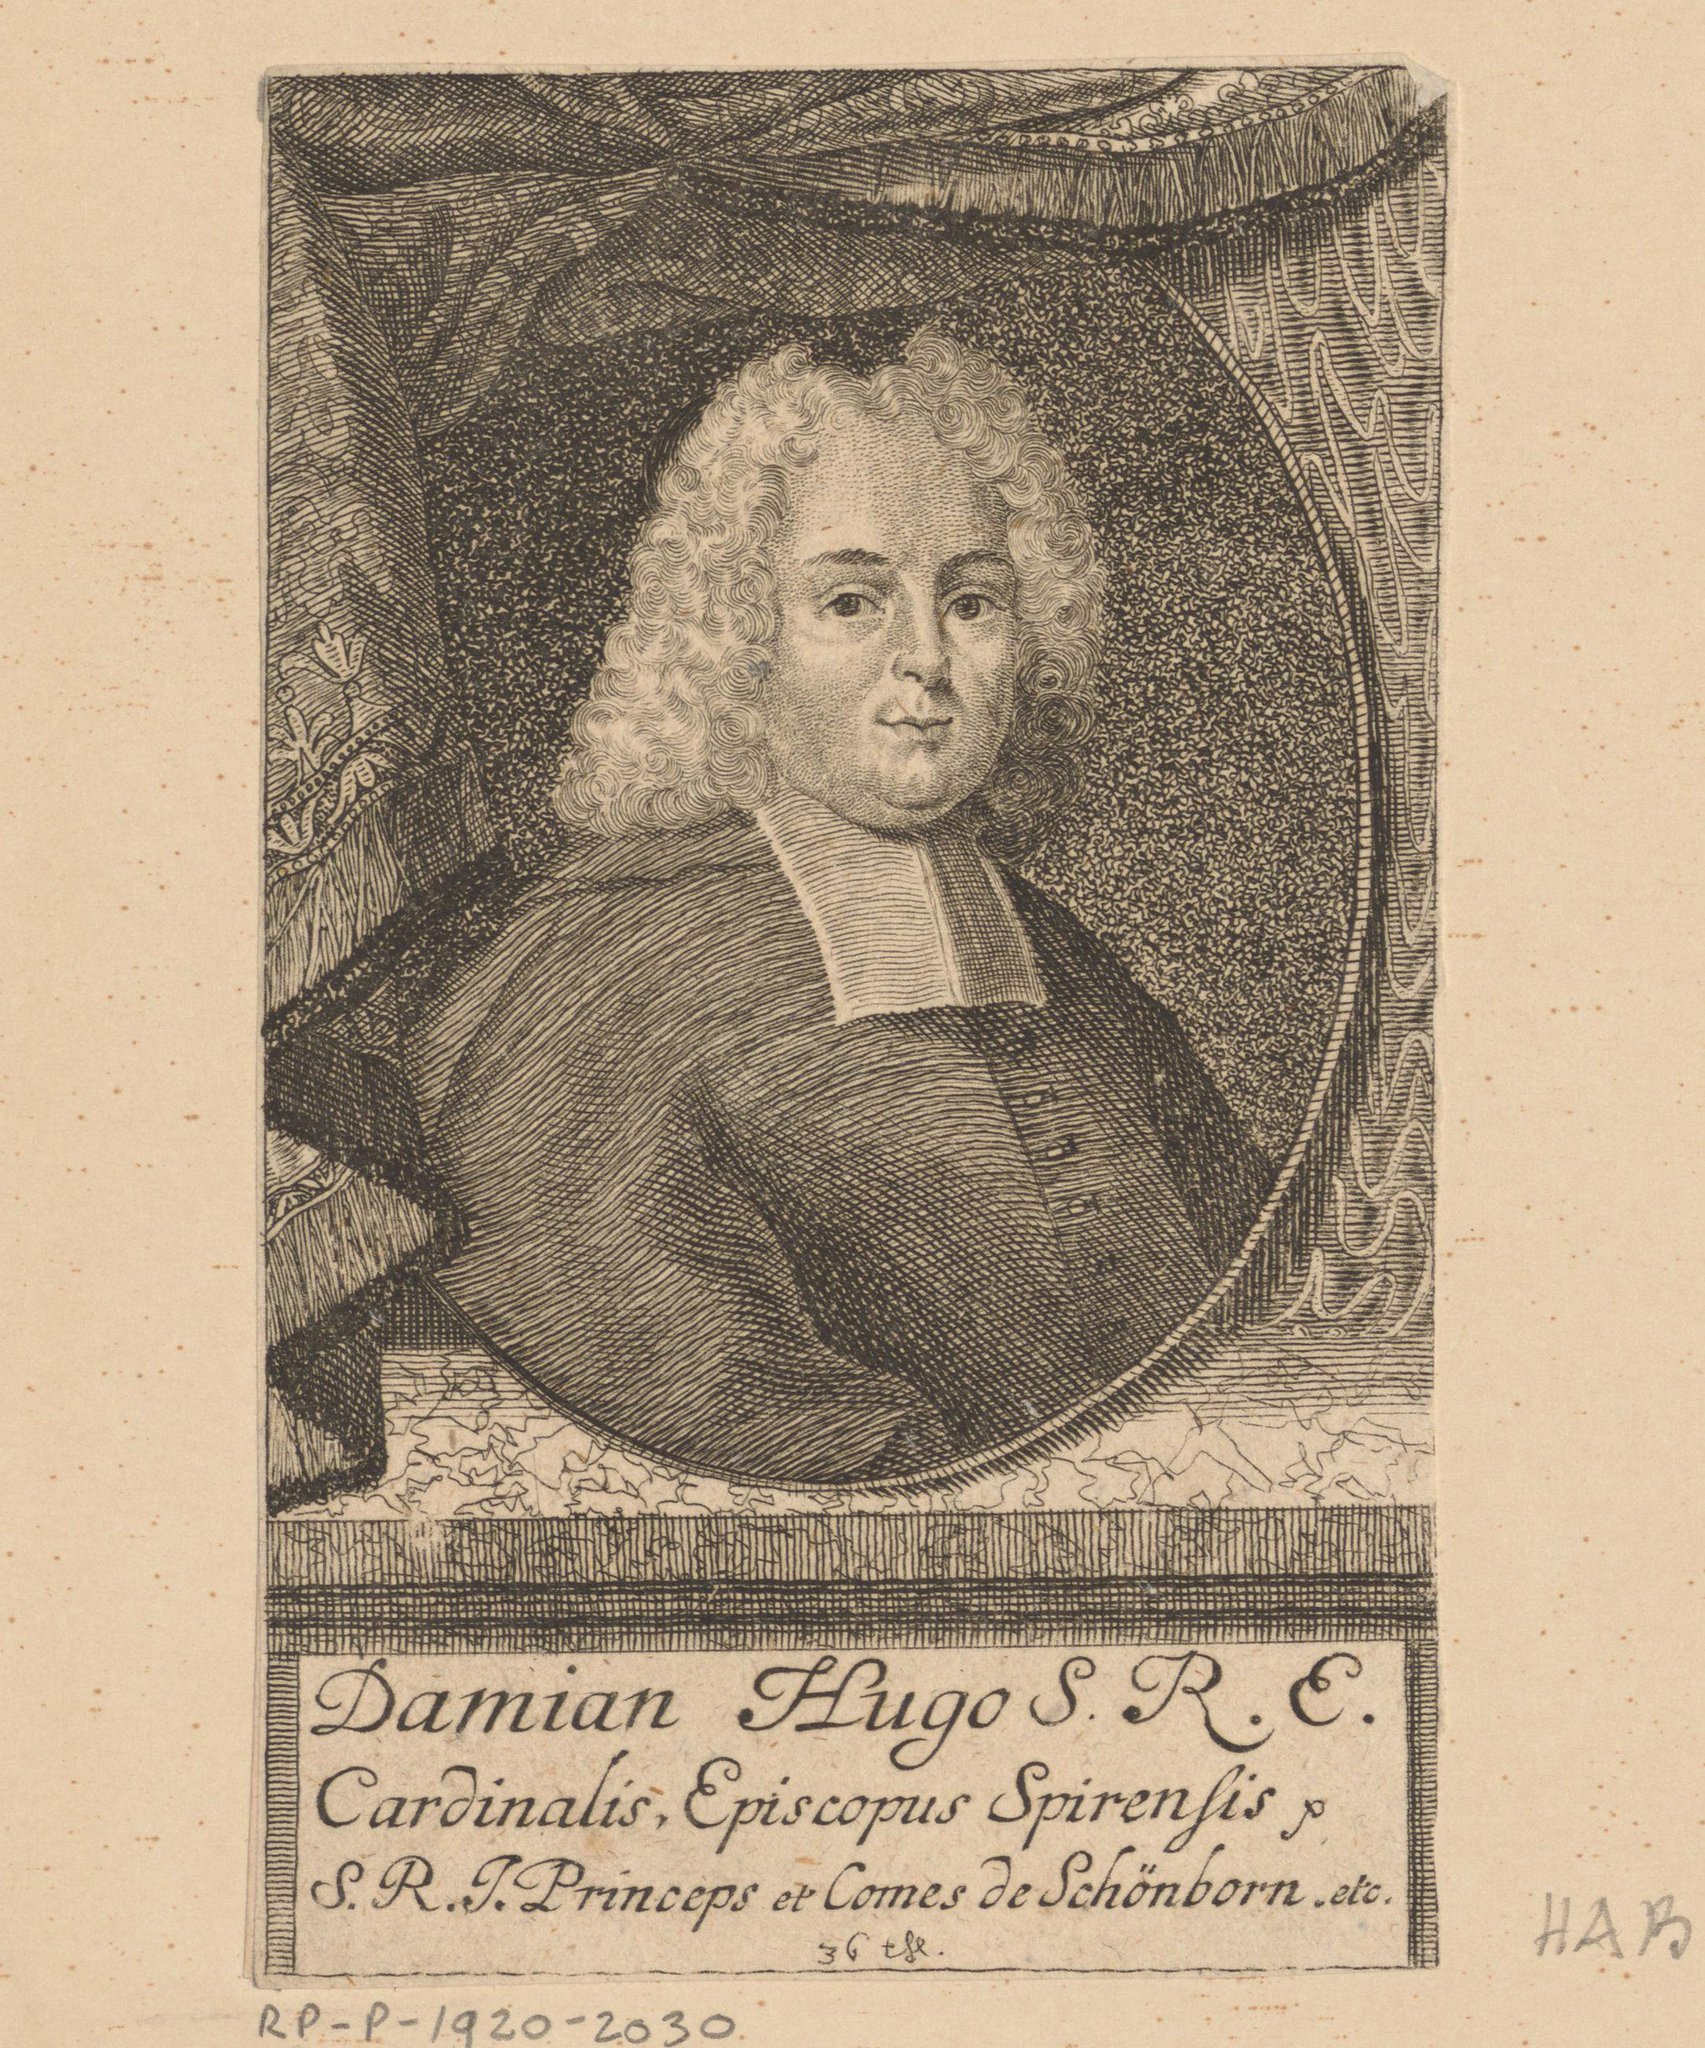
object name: print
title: Portret van Damian Hugo Philipp, graaf van Schönborn en Reichelsberg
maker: Anonymous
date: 1721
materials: paper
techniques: engraving, etching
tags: archbishop, bishop, etc. (roman catholic), cardinal, historical persons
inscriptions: collector's mark: Lugt 2228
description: Prent waarschijnlijk uit: Die Europäische Staats-Cantzley. S.l.: Christian Leonhard Leucht, 1721, dl. 36.